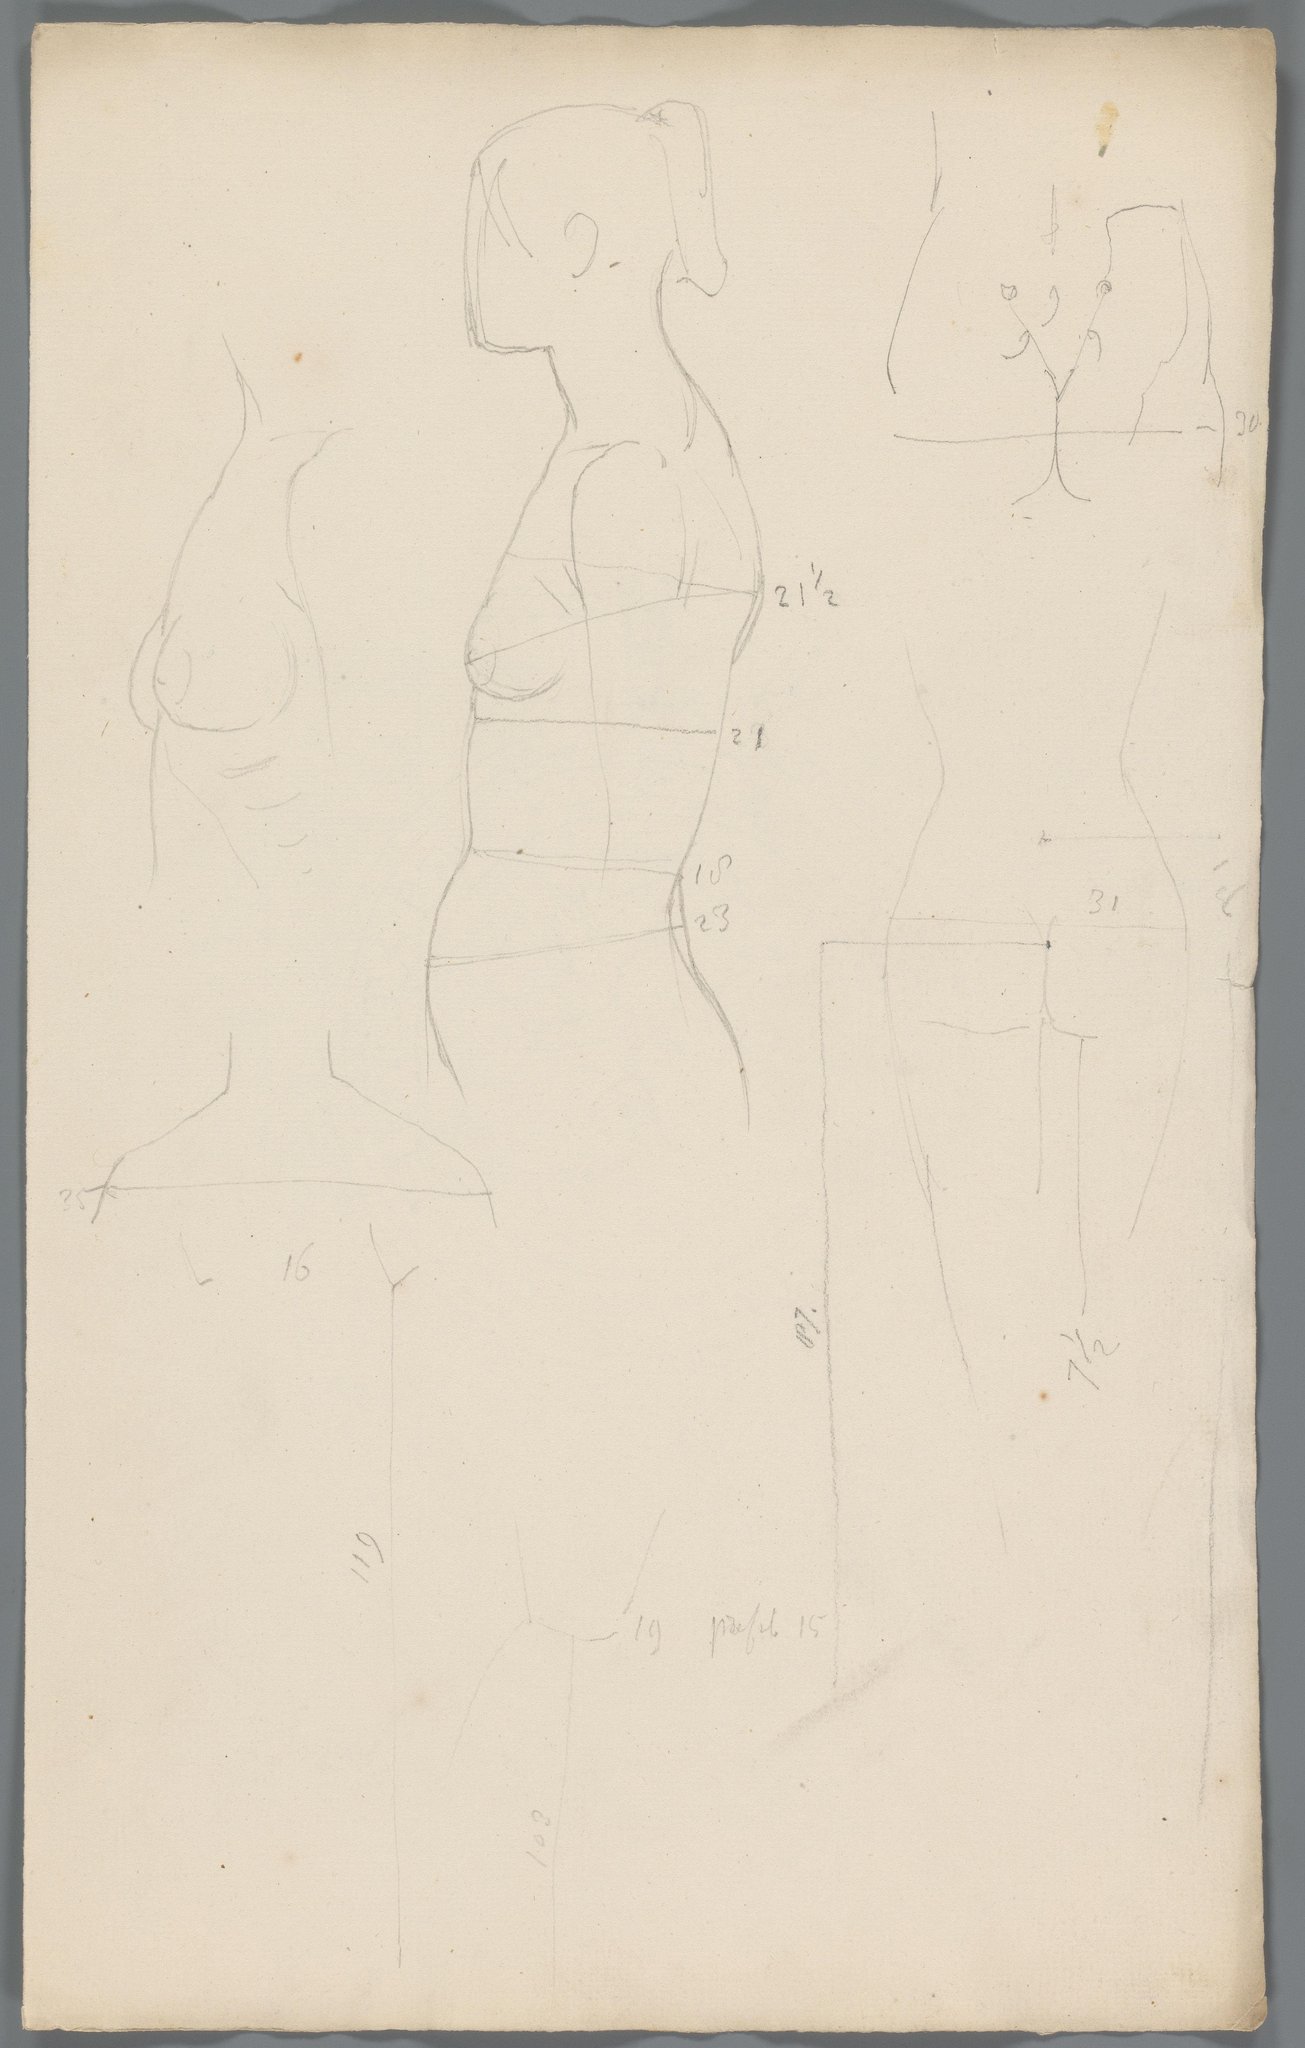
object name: drawing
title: Proportiestudies van een vrouw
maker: jacobus everhardus josephus van den berg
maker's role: draughtsman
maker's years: 1802-1861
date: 1812-1861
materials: paper, pencil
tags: standing figure (canon, proportions) - aa - female human figure, the (nude) human figure; 'corpo humano' (ripa) - aa - female human figure